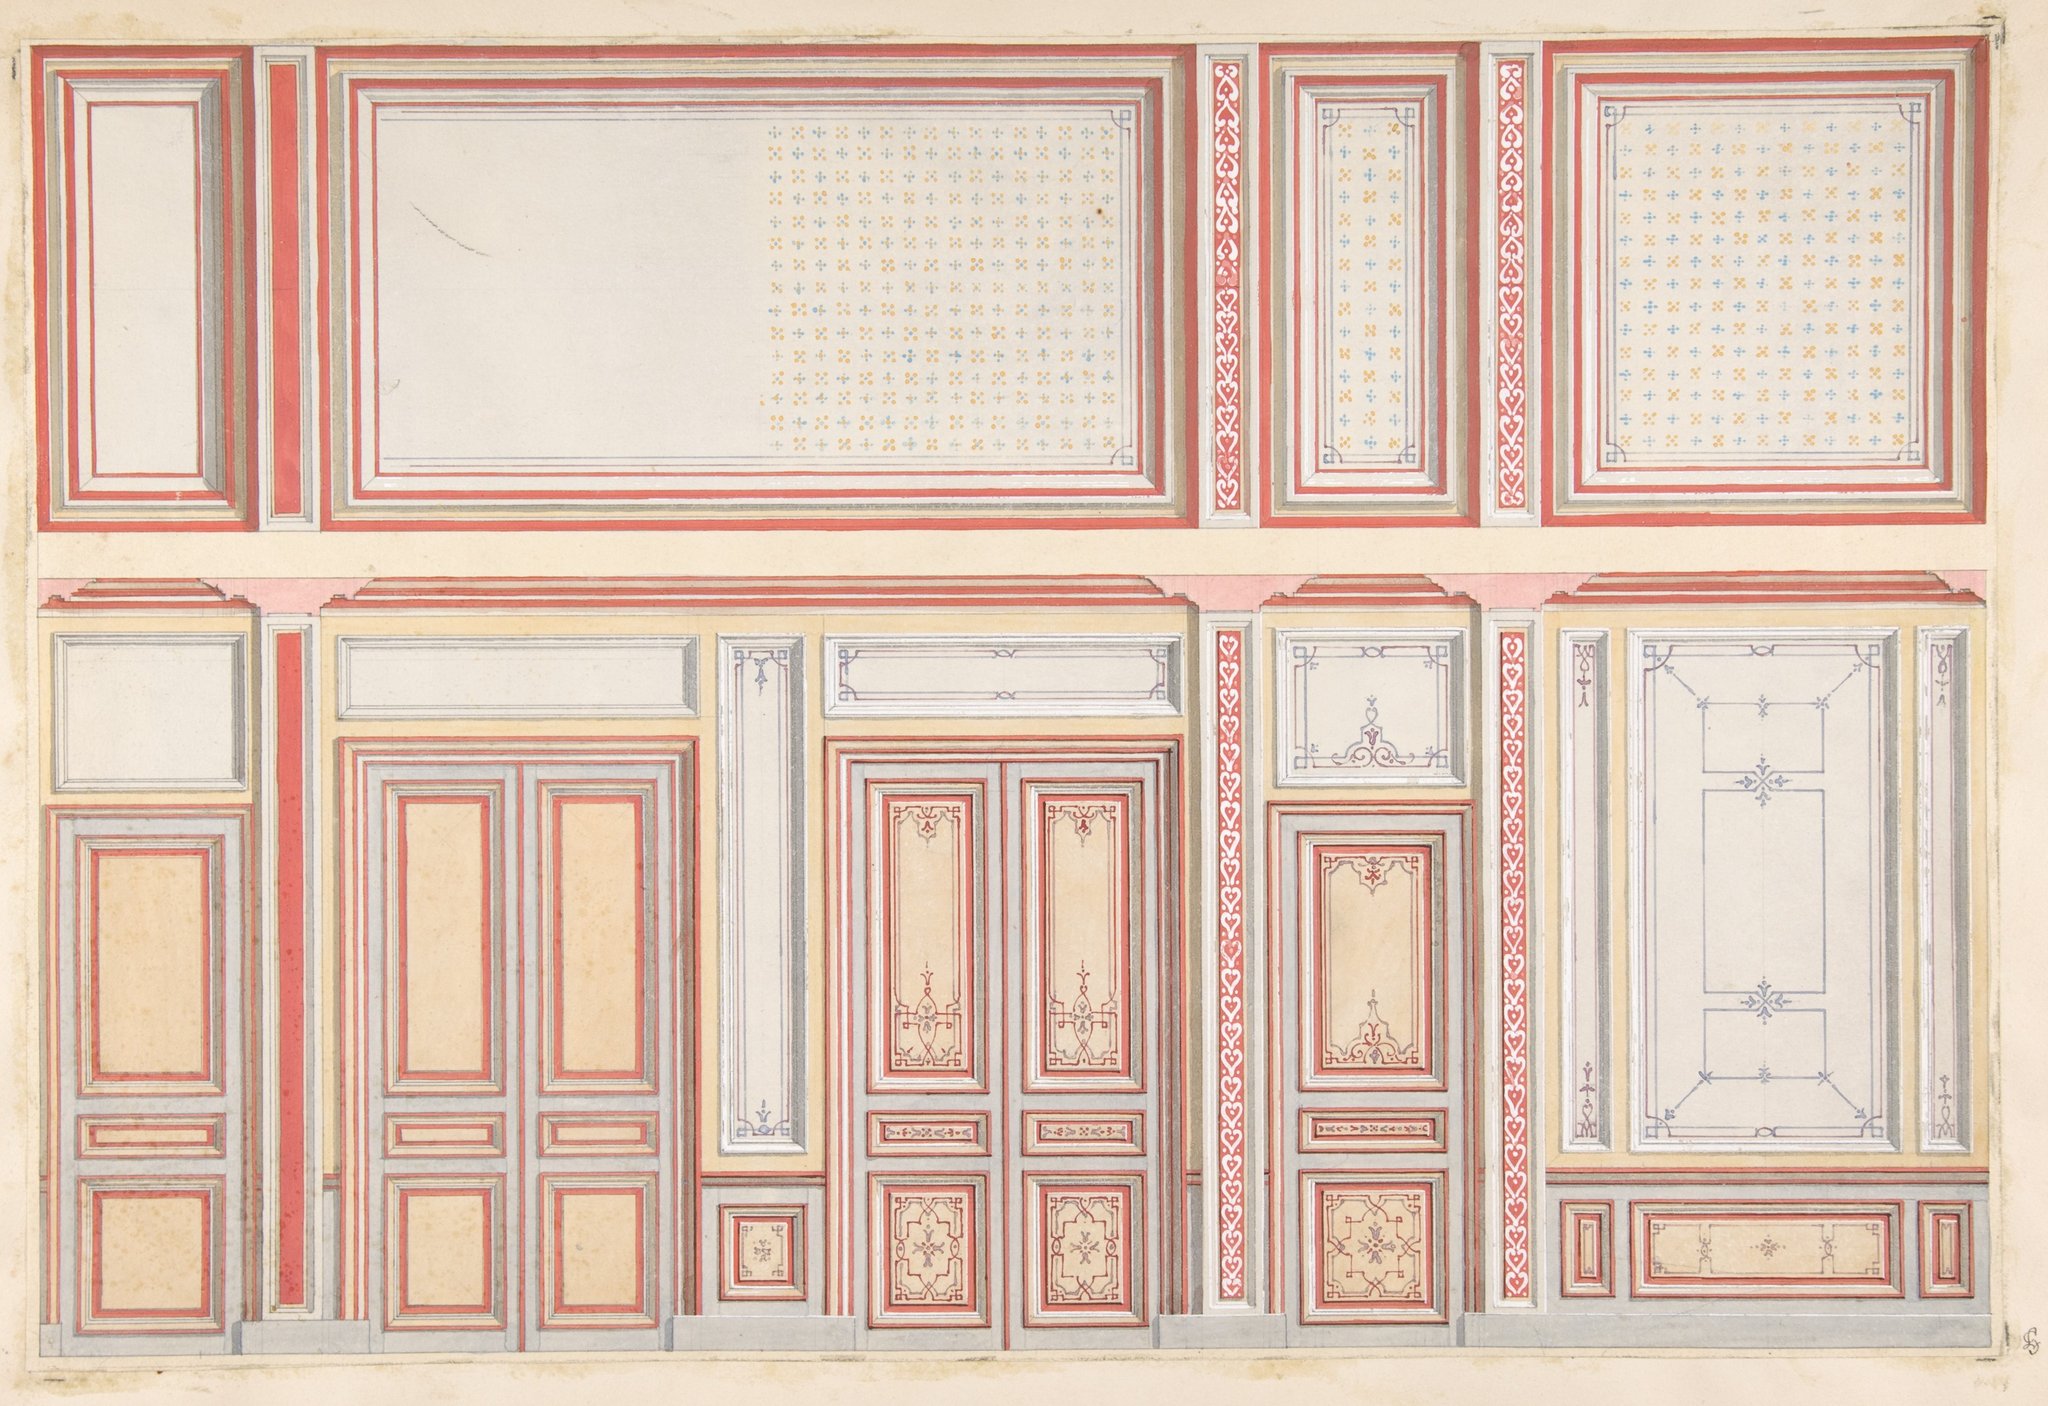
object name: drawing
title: Two designs for wall panels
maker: jules-edmond-charles lachaise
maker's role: artist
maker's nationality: french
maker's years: 1897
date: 1851-1900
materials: gilt, gouache, graphite, watercolor